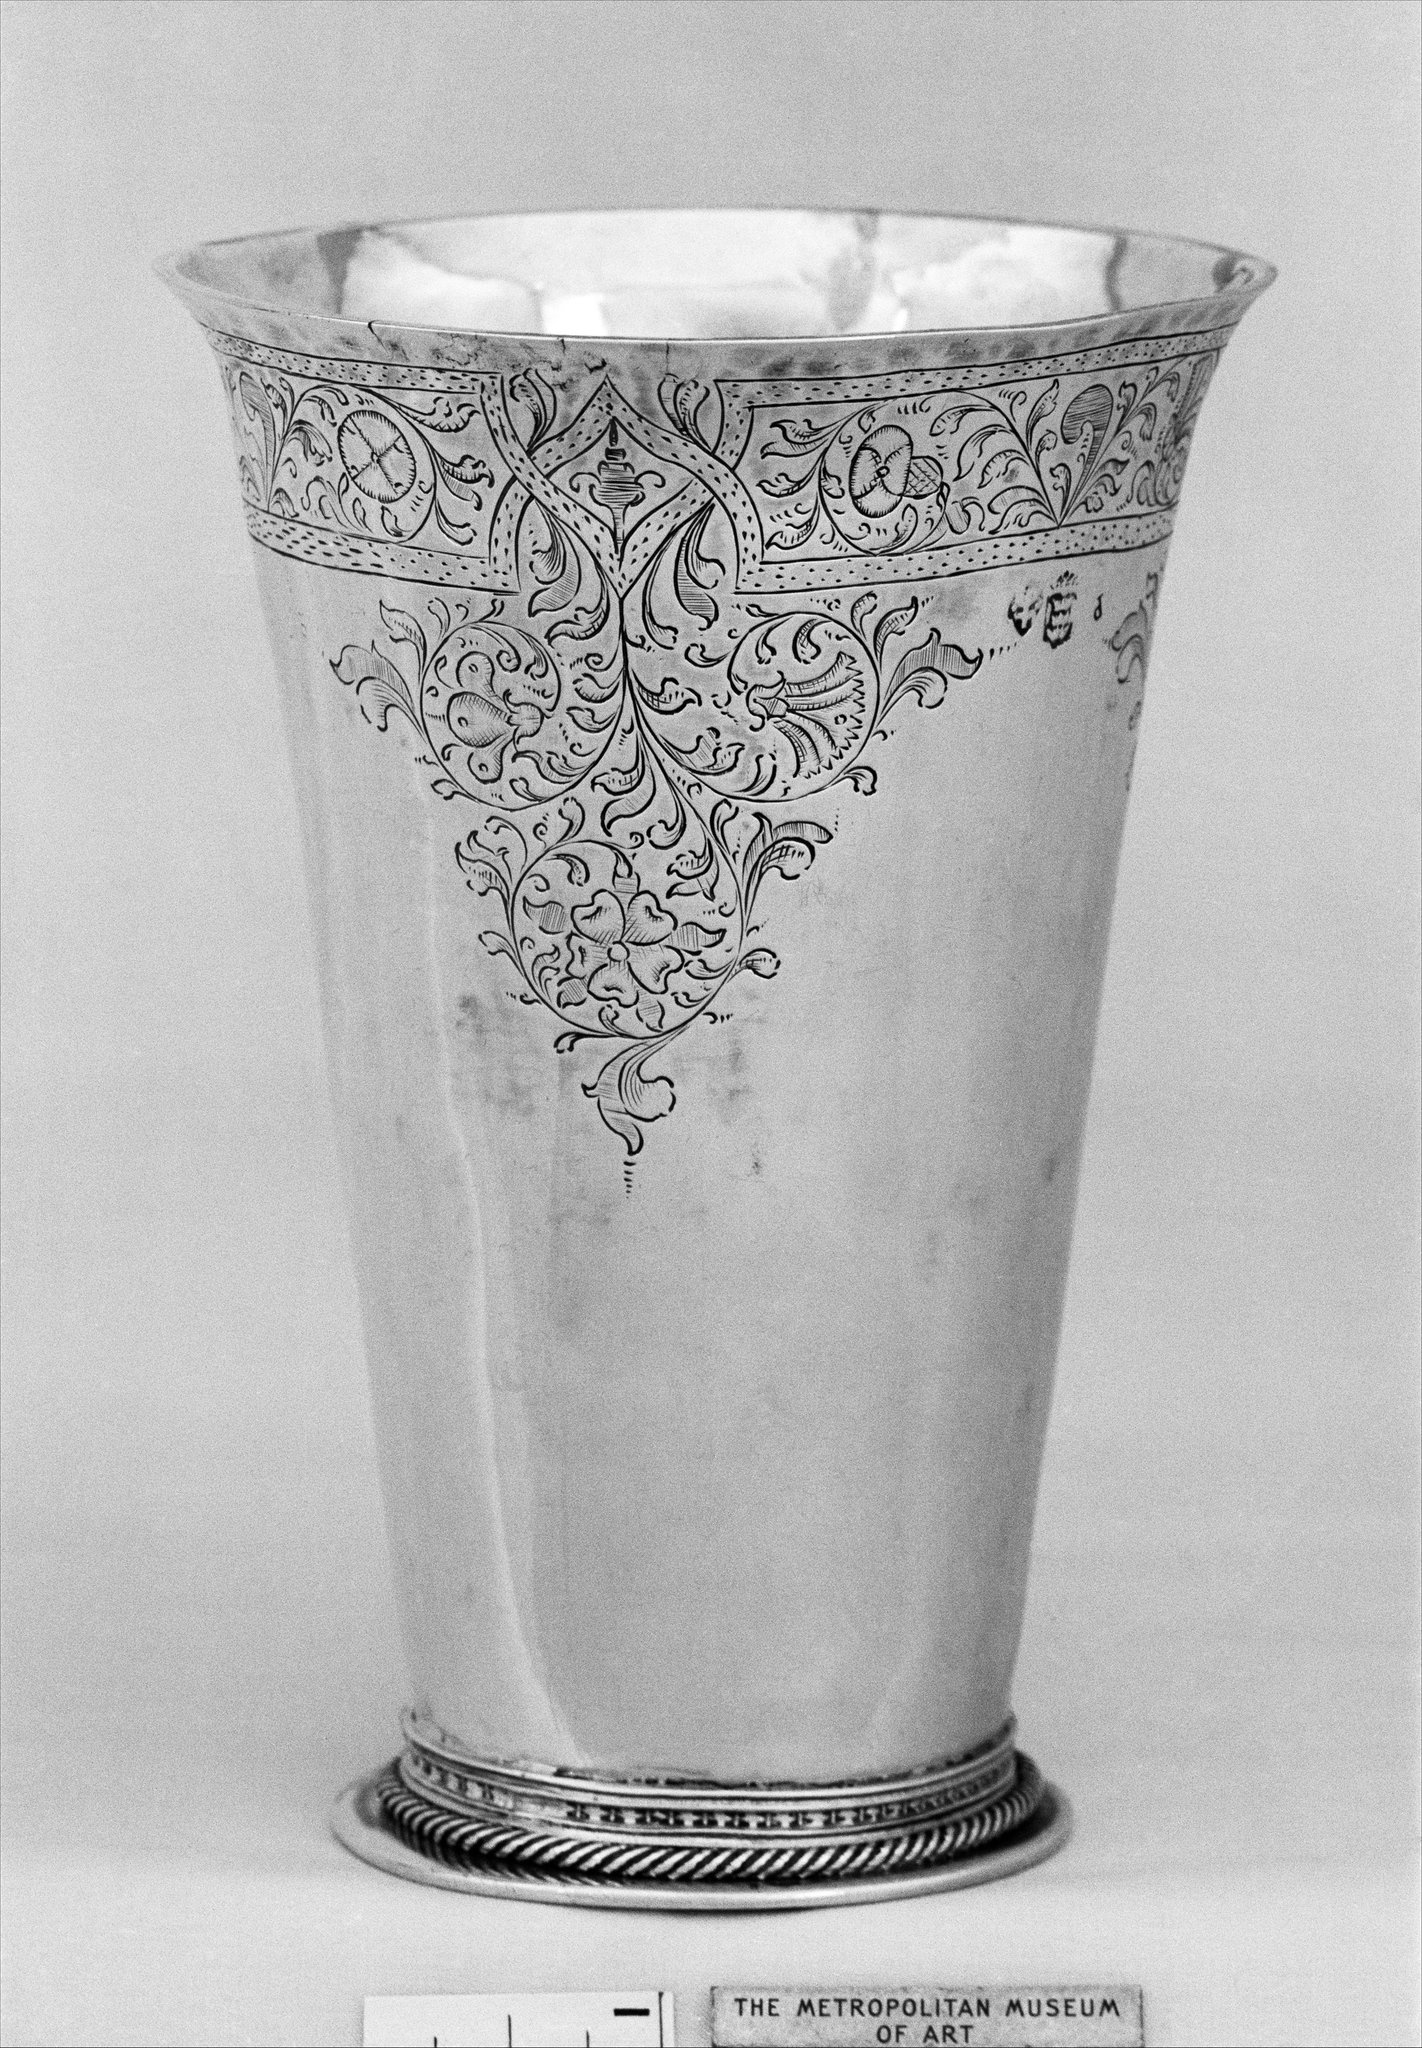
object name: beaker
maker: frans jans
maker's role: maker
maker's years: 1591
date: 1615-1620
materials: silver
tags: flowers